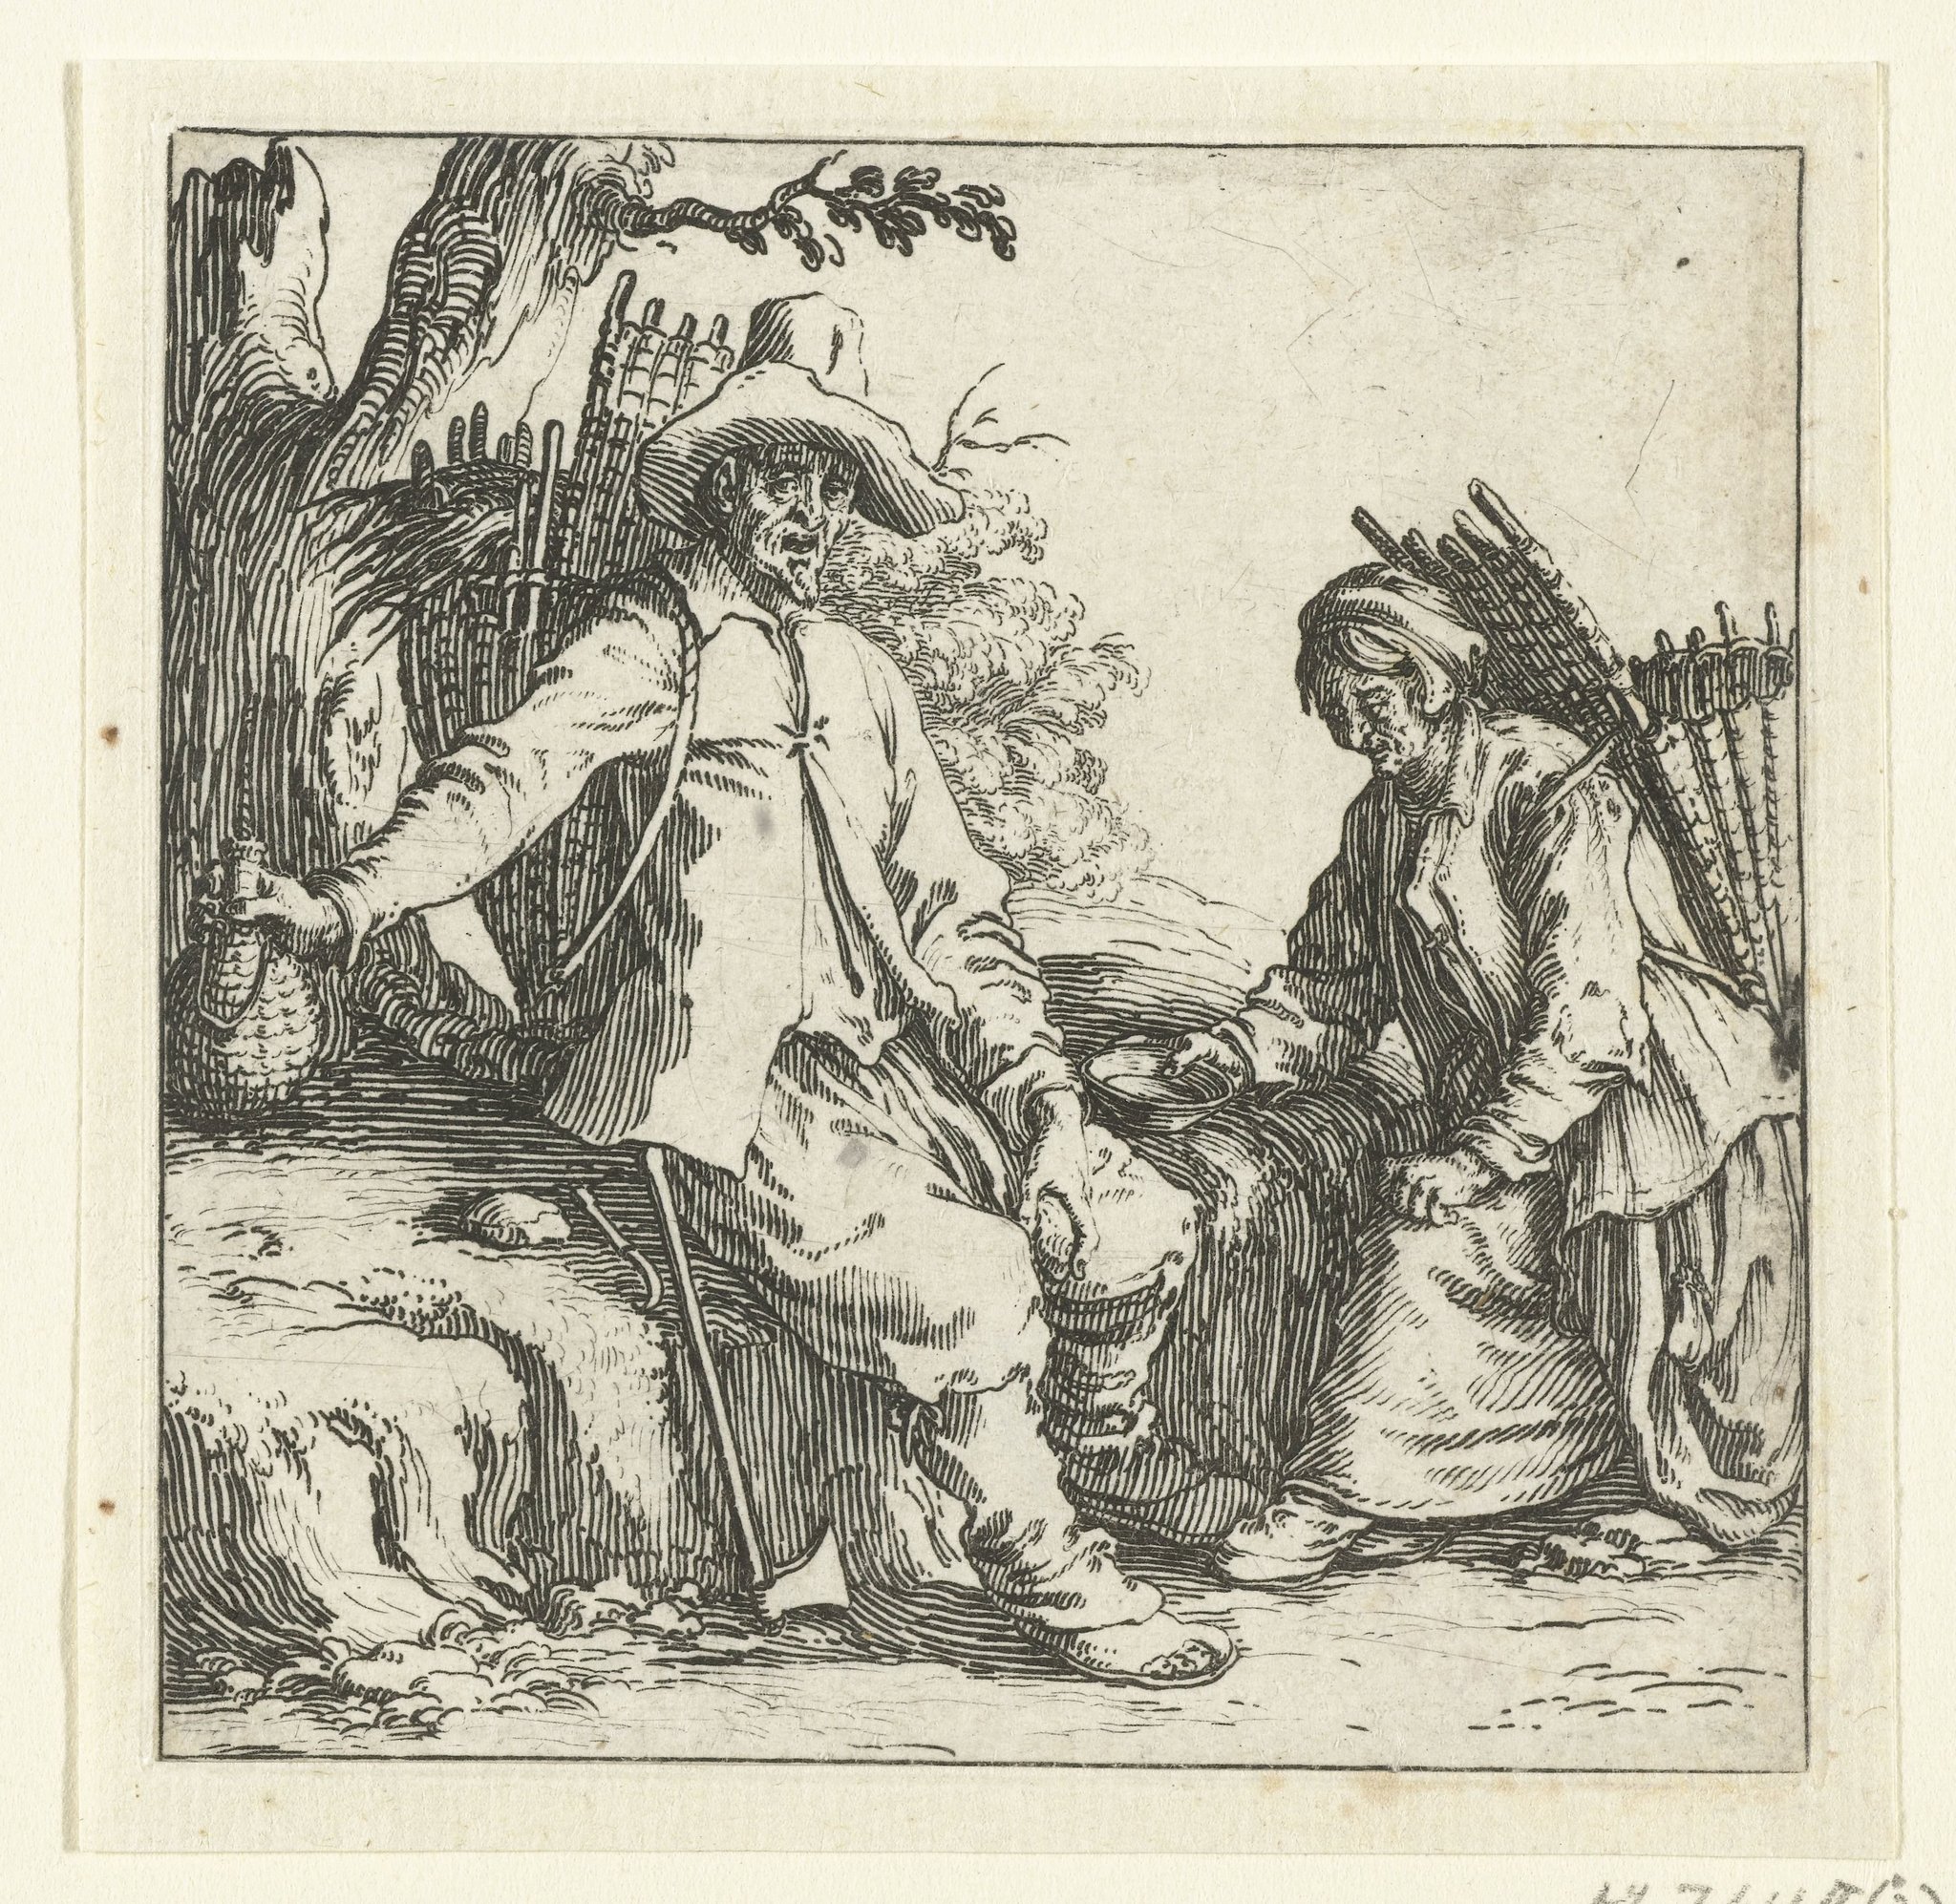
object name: print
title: Varie figure di Jacopo Callot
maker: jacques callot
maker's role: draughtsman, print maker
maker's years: 1592-1635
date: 1621-1624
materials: paper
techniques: etching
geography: nancy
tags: farmers, container made of plant material other than wood: basket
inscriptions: collector's mark: Lugt 240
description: Een boer en een boerin, beiden met een rieten mand op de rug, rusten uit aan de kant van een weg. De boer pakt een fles, de boerin pakt een kom. Deze prent is onderdeel van een serie van 16 prenten (15 volgens Lieure; 17 resp. 16 incl. titelprent) met mannen en vrouwen in diverse houdingen. Mogelijk zijn deze prenten bedoeld geweest als tekenvoorbeelden.